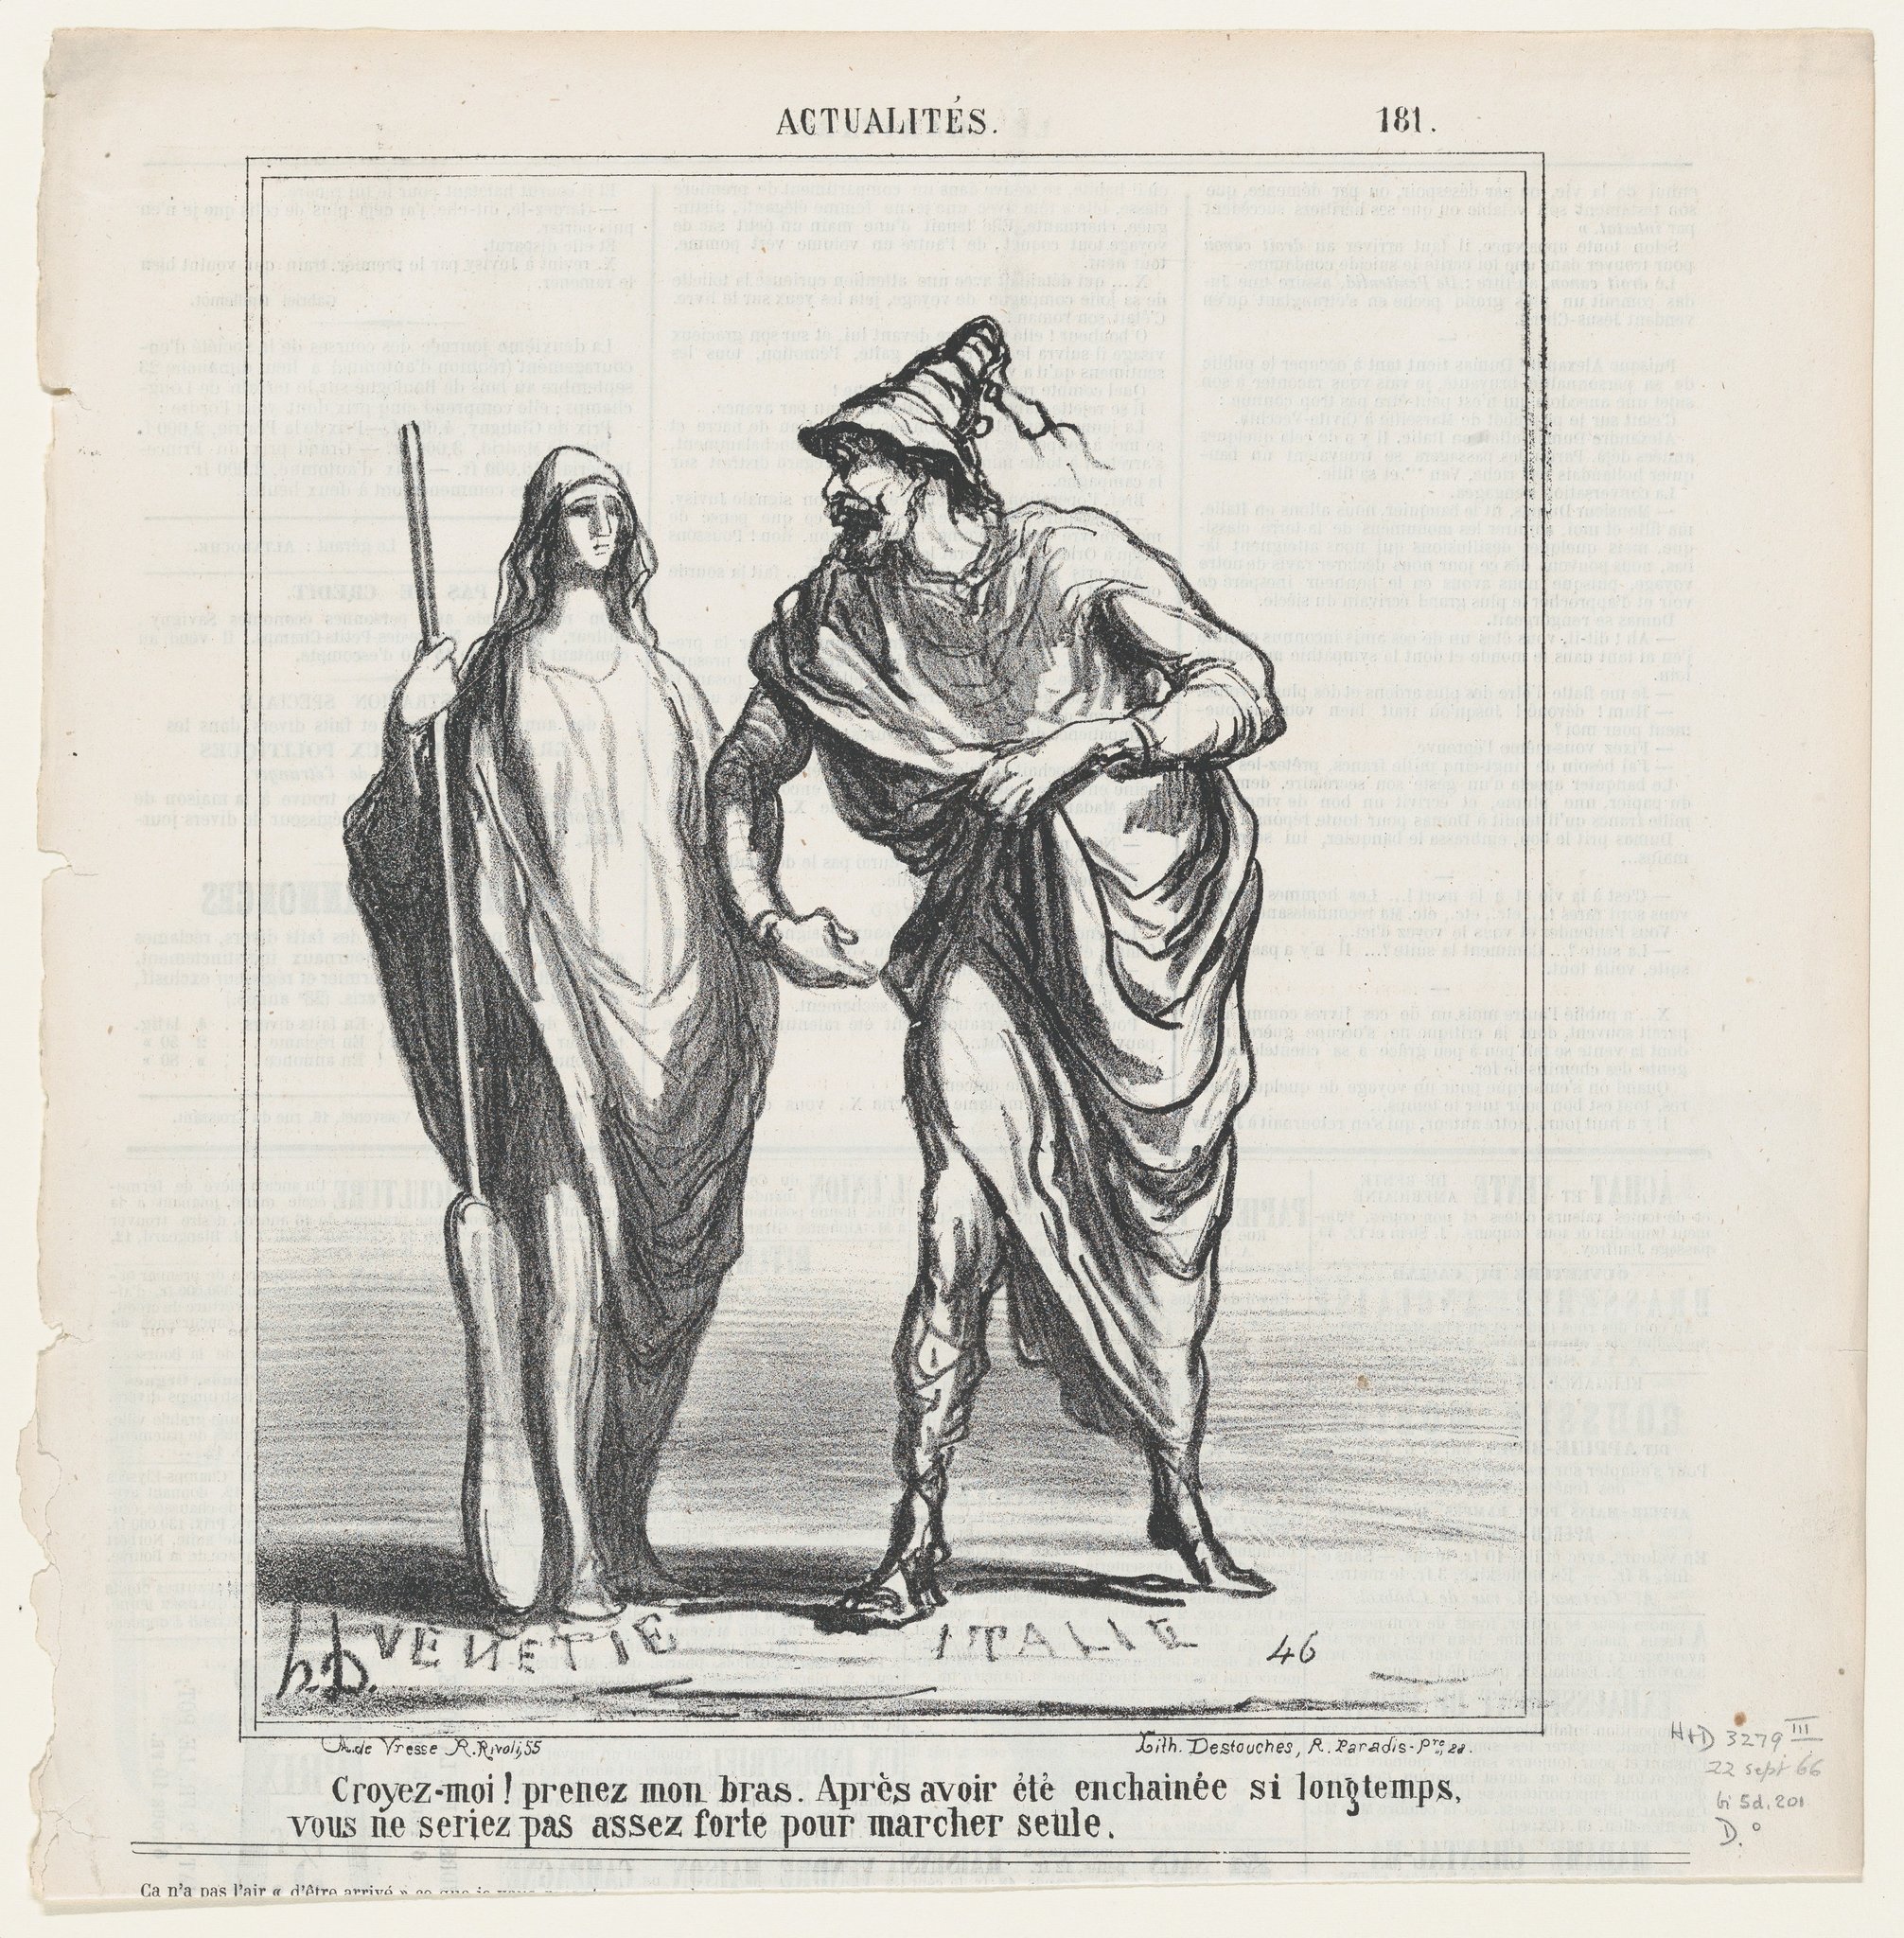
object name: print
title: Believe me, take my arm! After having been chained for such a long time you will not be strong enough to walk on your own!, from 'News of the day,' published in Le Charivari, September 22, 1866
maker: honoré daumier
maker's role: artist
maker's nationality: french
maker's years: 1808-1879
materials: paper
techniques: lithograph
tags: men,women